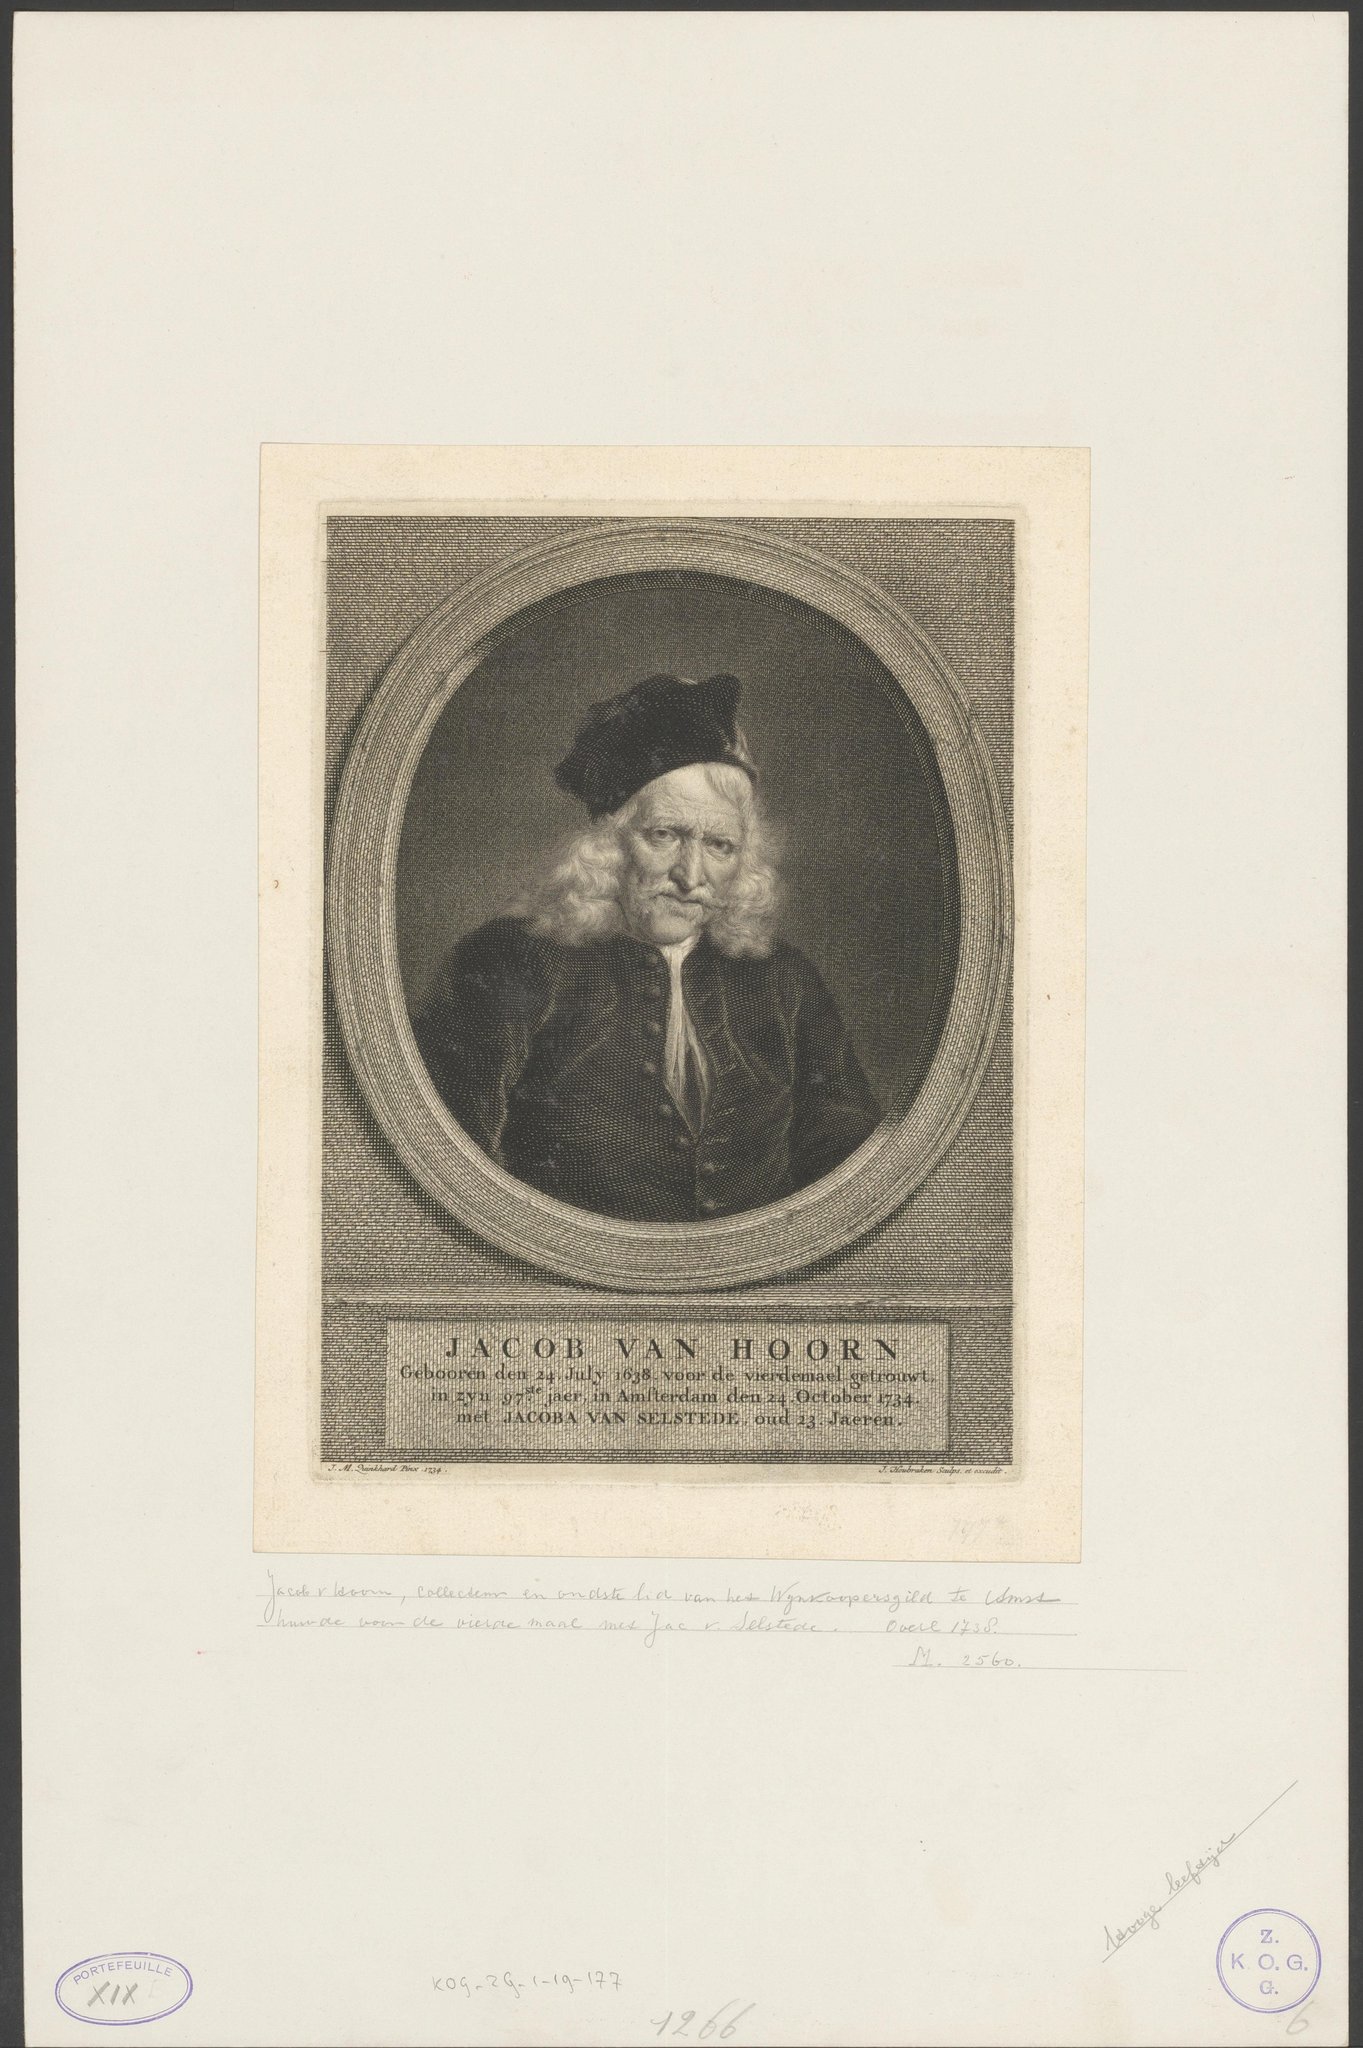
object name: print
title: Jacob van Hoorn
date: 1734-1736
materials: paper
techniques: engraving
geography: amsterdam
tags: old man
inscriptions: collector's mark: Lugt 1641, collector's mark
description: Portret van Jacob Hoorn (1638-1734) in een ovale architectonische omlijsting. Onder het portret een plint waarop zijn naam en gegevens in vier regels in het Nederlands. Collecteur en oudste lid van het Wijnkoopersgilde te Amsterdam. Overleden op 97-jarige leeftijd. Onderwerpsrubrieken binnen de Atlas Zeden en Gewoonten: Des Menschen Begin, Midden en Einde. Hooge leeftijd.